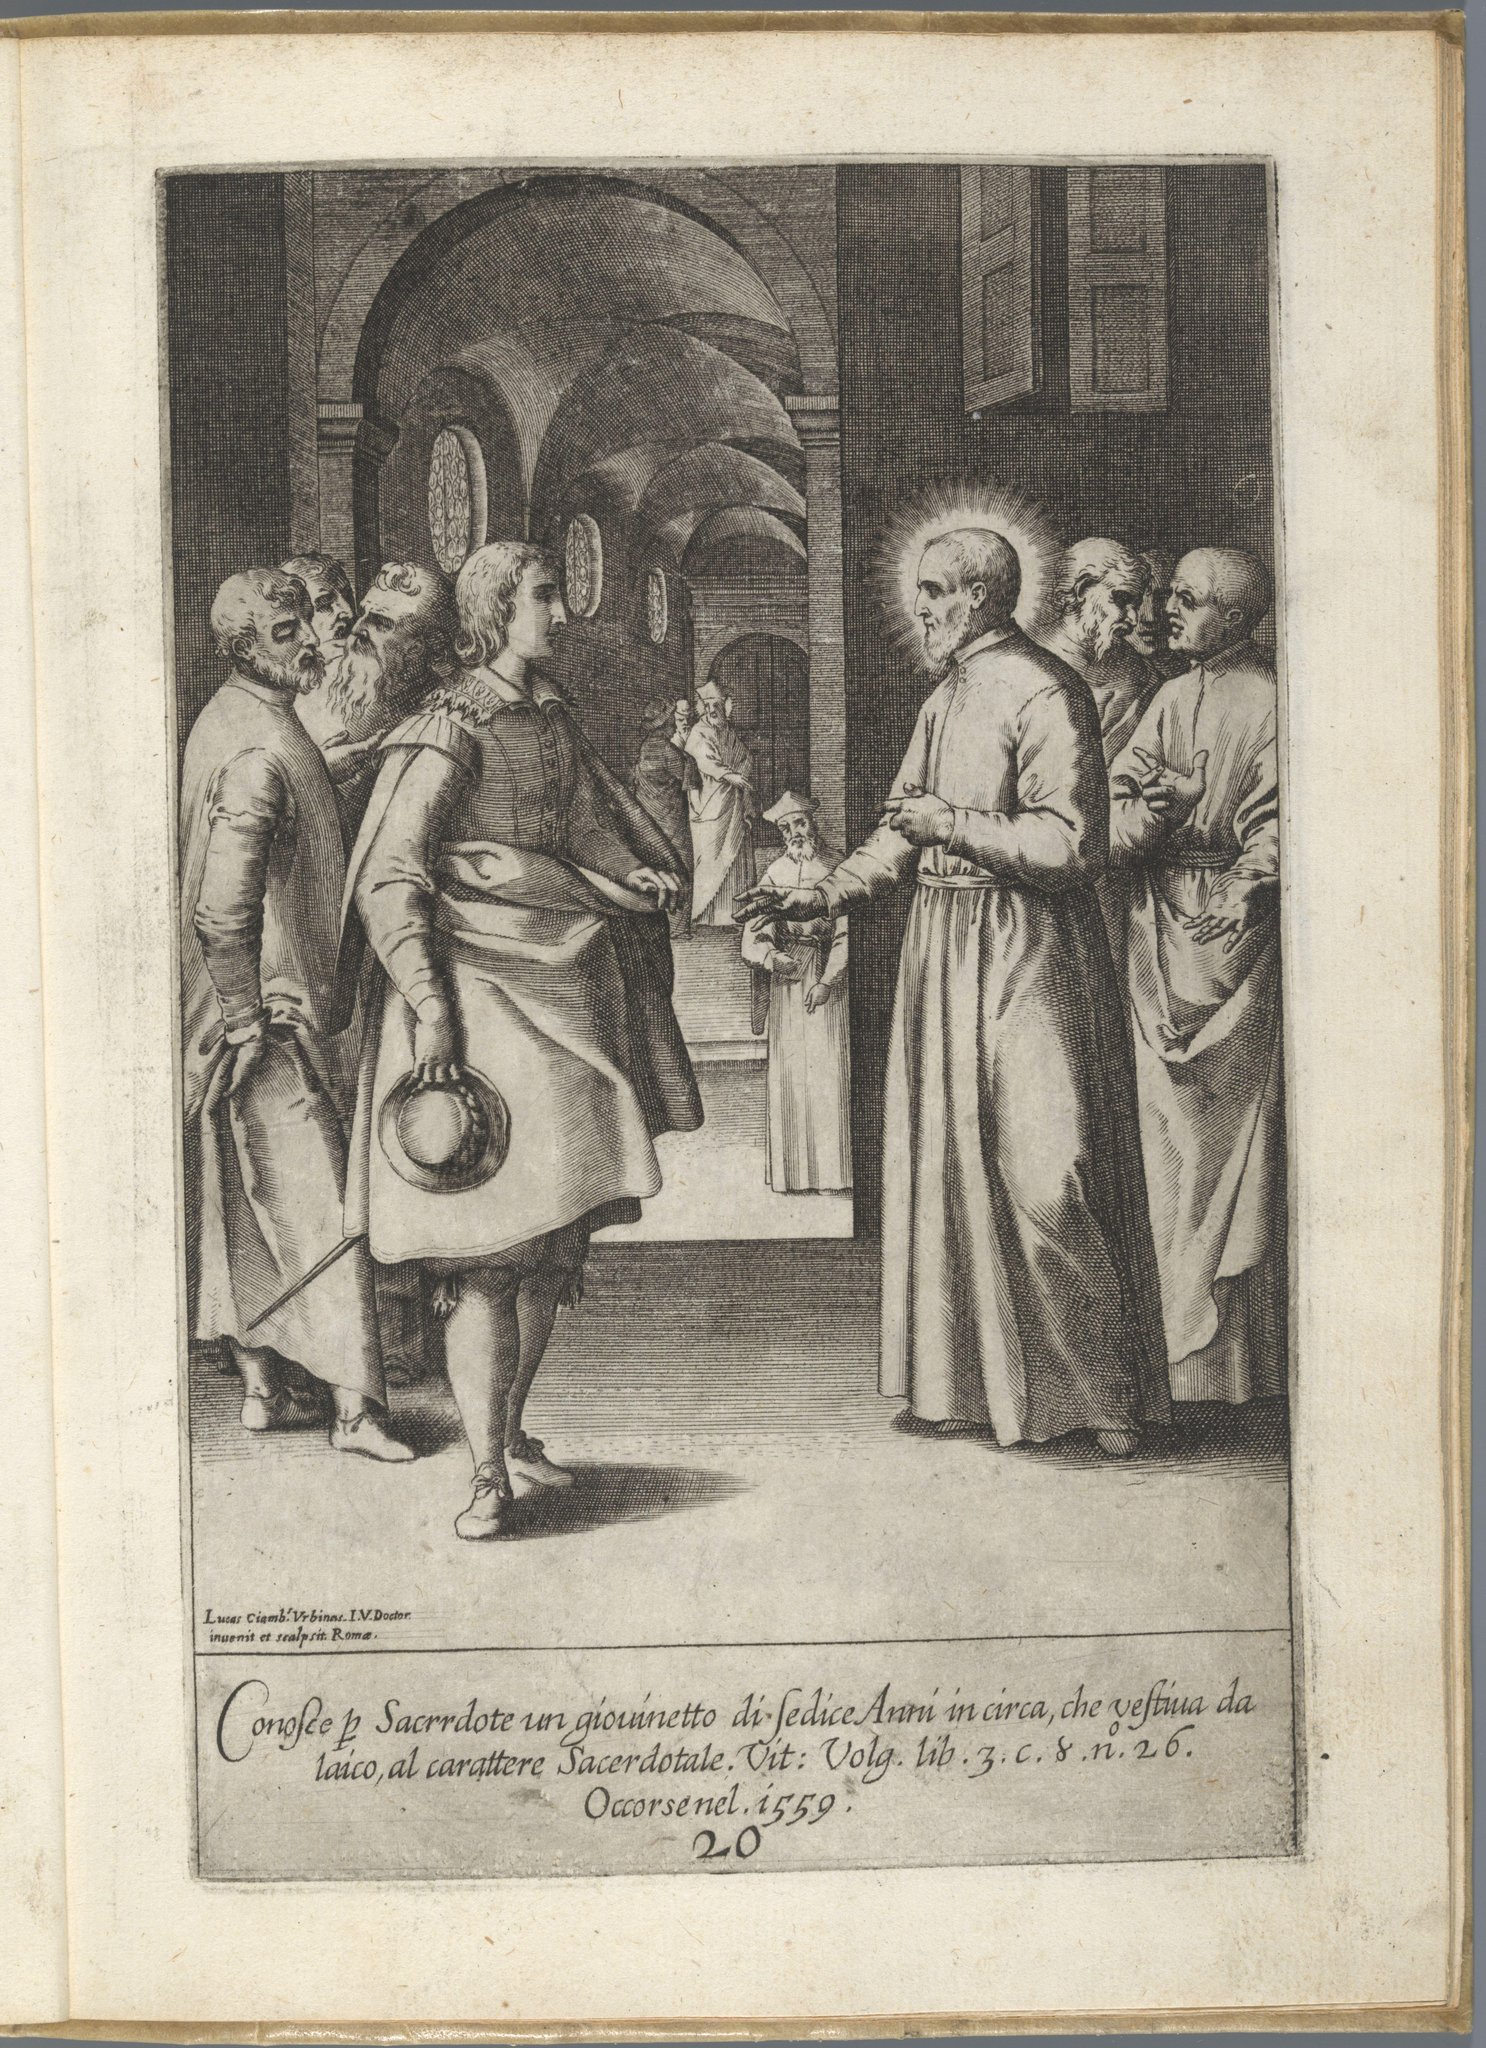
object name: print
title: Leven van de heilige Filippo Neri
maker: luca ciamberlano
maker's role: painter, print maker, publisher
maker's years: 1570-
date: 1630-1641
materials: paper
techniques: engraving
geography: rome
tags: rome, clergyman, the founder of the congregation of the oratory (oratorians) philip neri; possible attributes: lily, rosary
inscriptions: collector's mark: Lugt 2760, collector's mark: Lugt 2228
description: Filippo Neri herkent een jongeman als priester (1559). Prent nr. 20 in een serie van 44 prenten met scènes uit het leven van de heilige Filippo Neri.